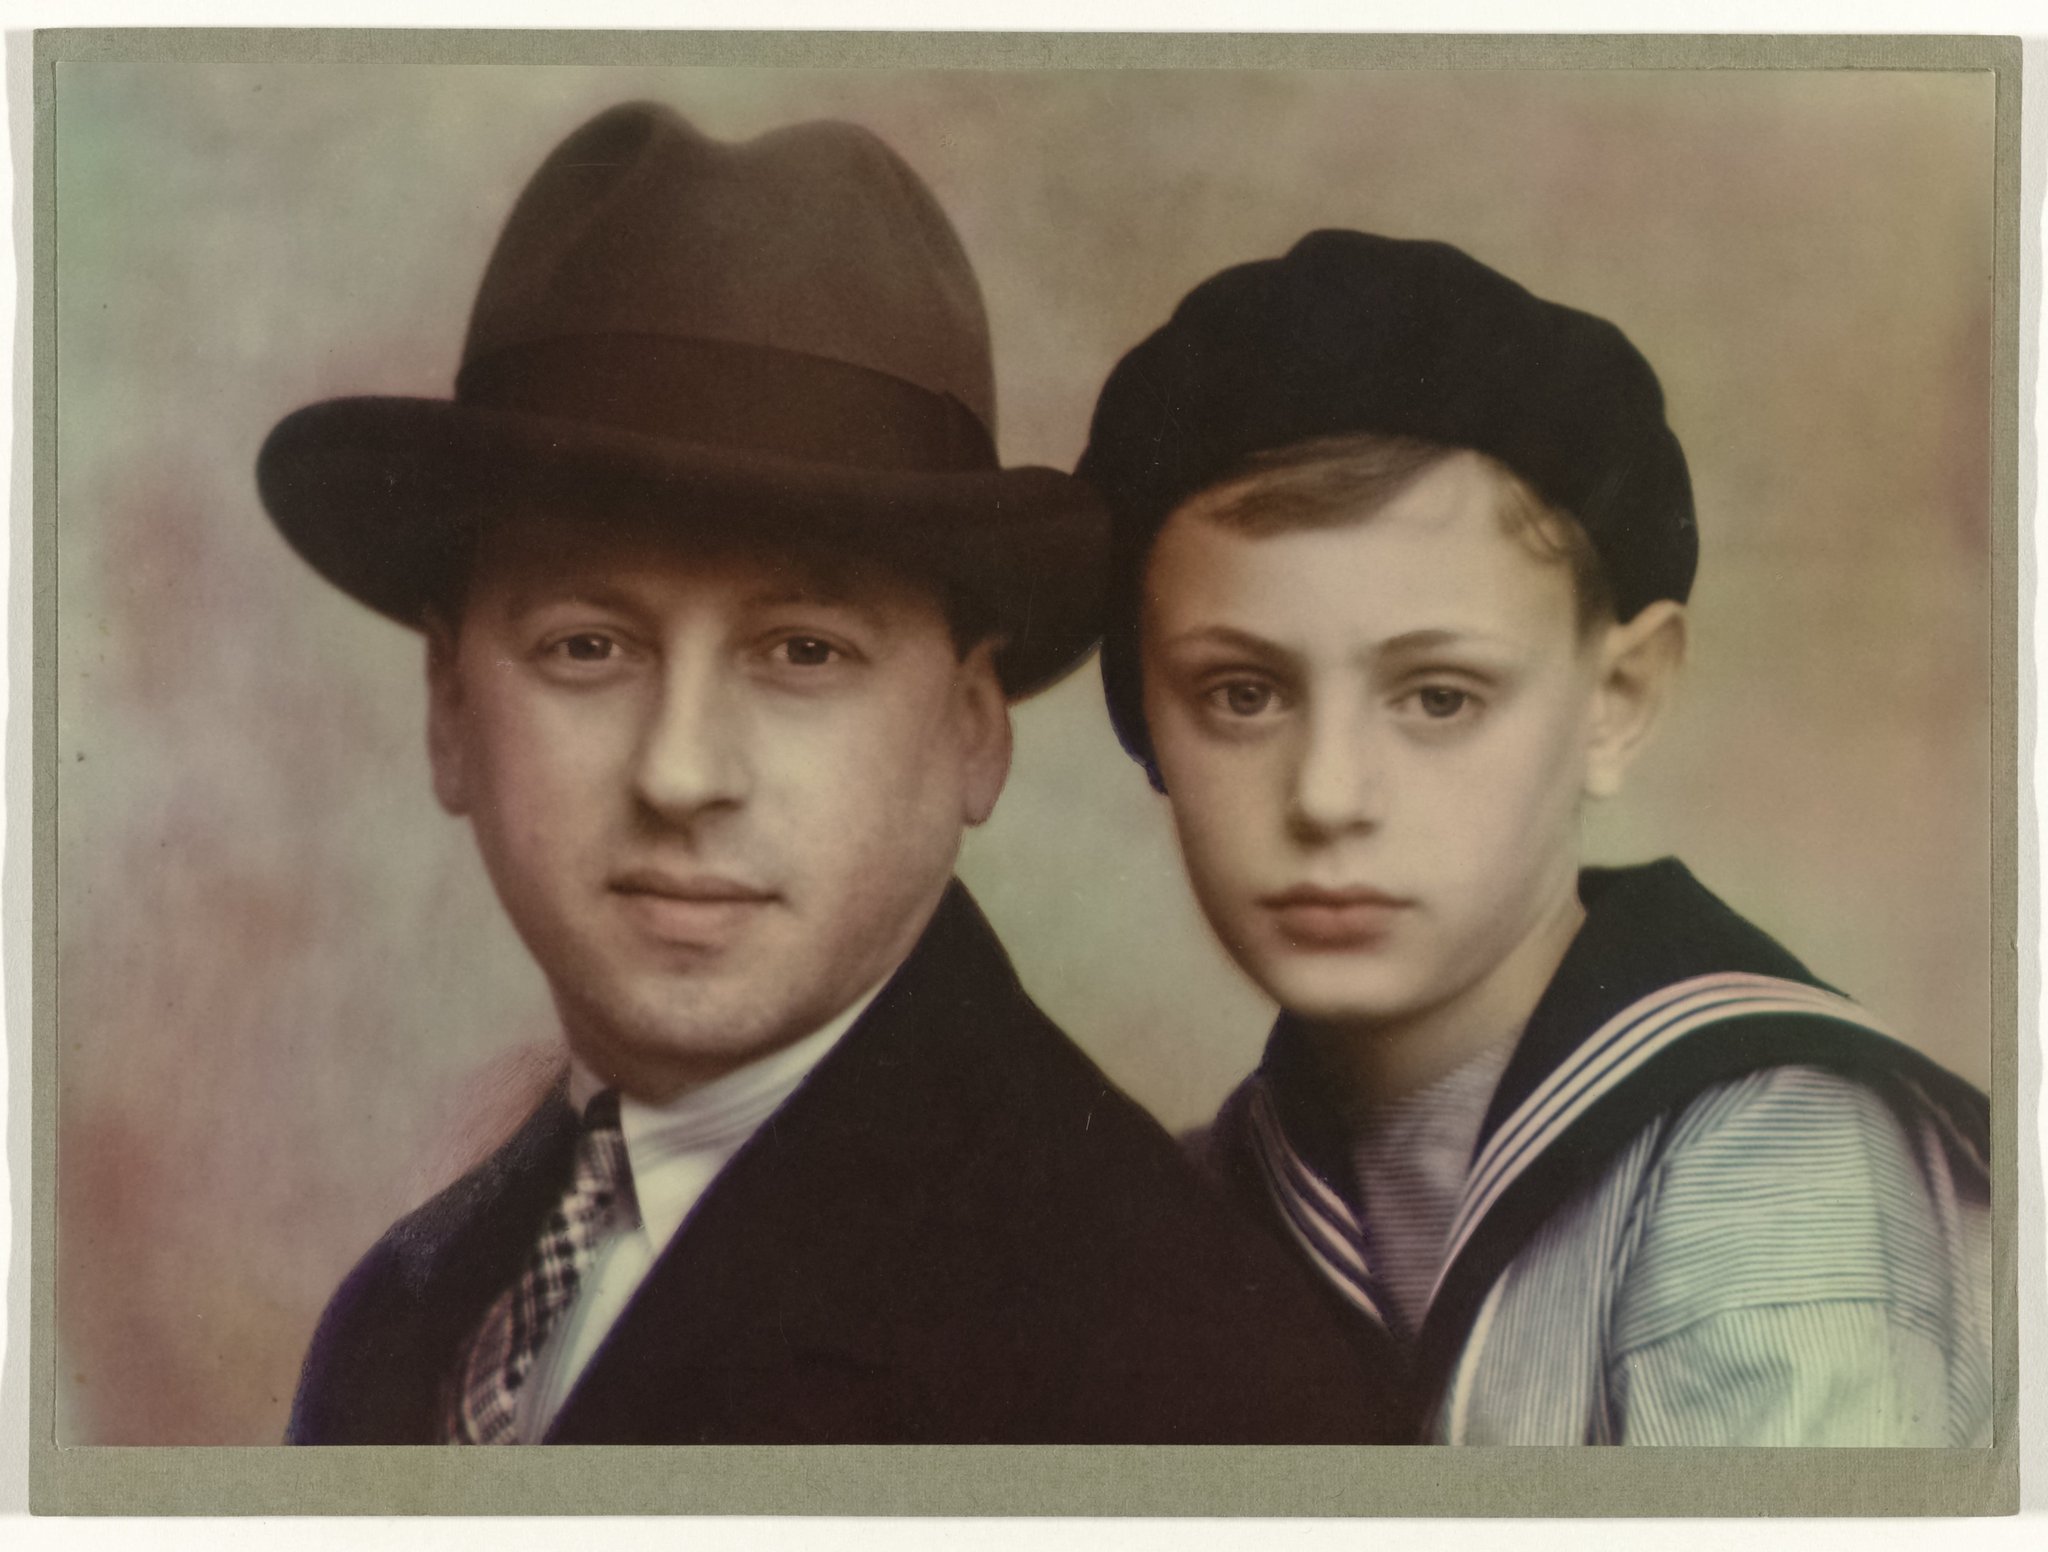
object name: photograph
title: Portret van vader en zoon in matrozenpak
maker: jacob merkelbach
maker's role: fotograaf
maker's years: 1877-1942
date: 1920-1930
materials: cardboard, photographic support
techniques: jos-pé print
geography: amsterdam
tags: father and son(s) (family group), historical persons (portraits and scenes from the life)